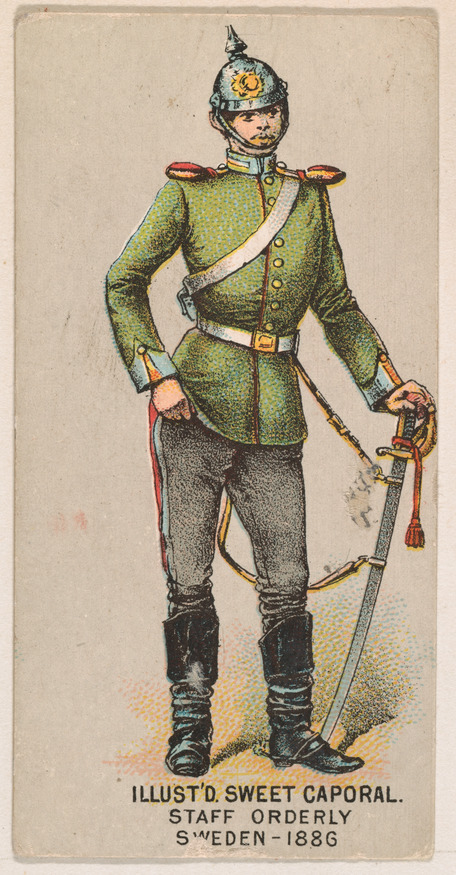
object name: print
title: Staff Orderly, Sweden, 1886, from the Military Series (N224) issued by Kinney Tobacco Company to promote Sweet Caporal Cigarettes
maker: kinney brothers tobacco company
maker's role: publisher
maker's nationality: american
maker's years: 1869-2011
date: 1888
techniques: color lithograph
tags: military,swords,men